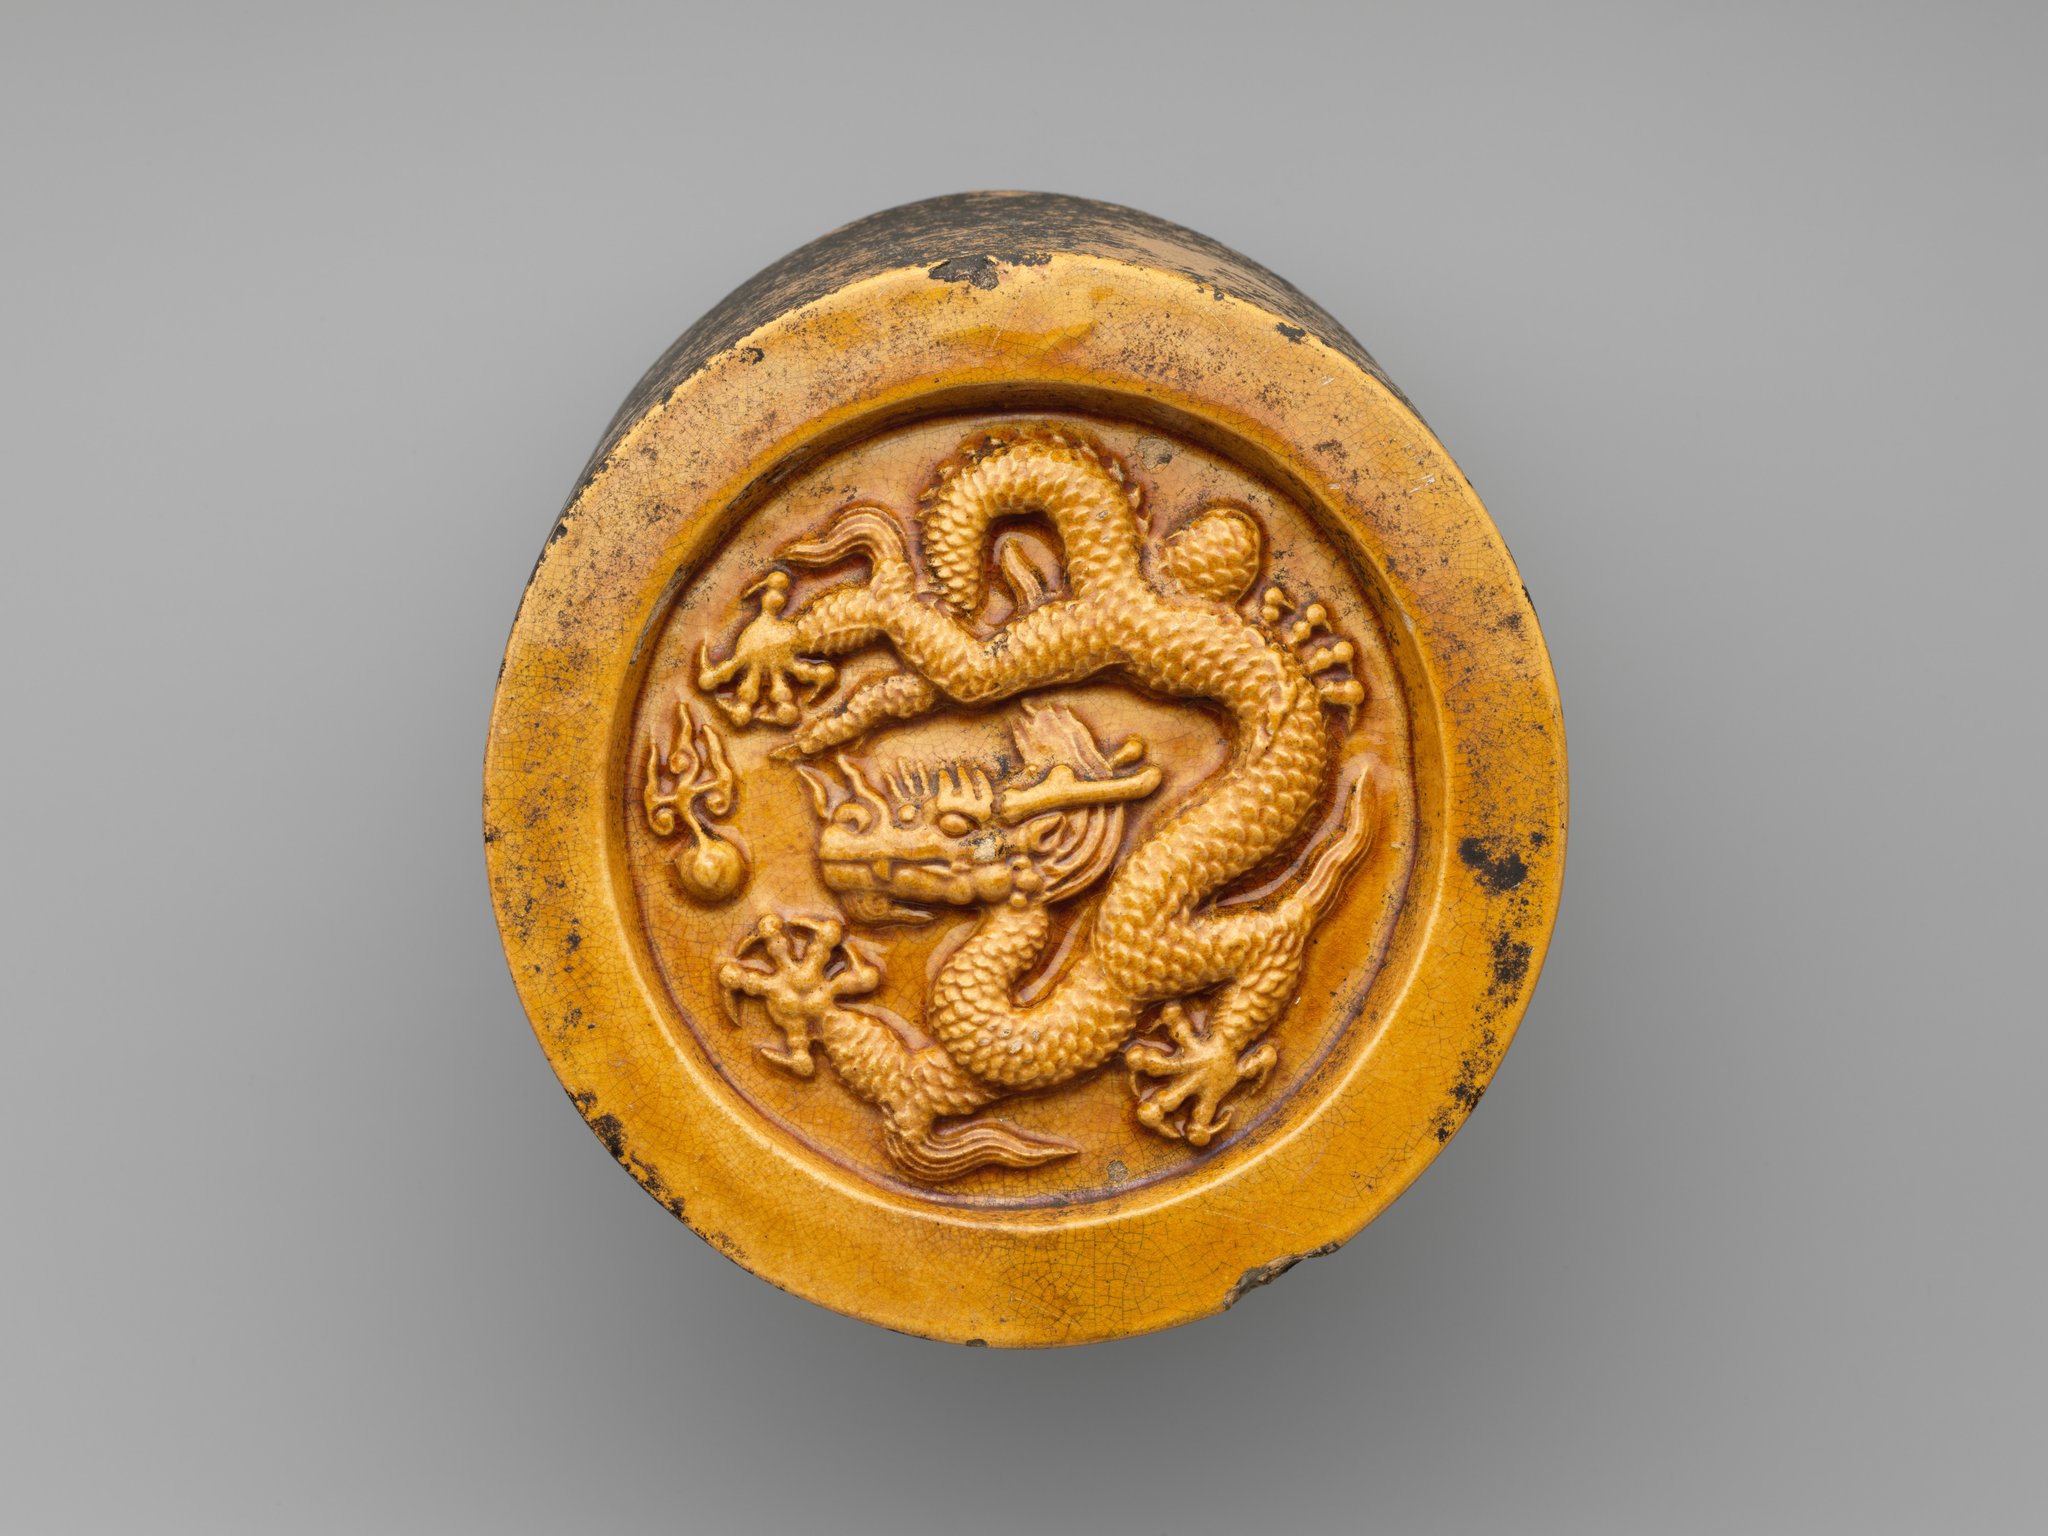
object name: roof tile end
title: Roof-tile end with dragon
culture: chinese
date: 1368-1644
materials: earthenware, glaze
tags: dragons